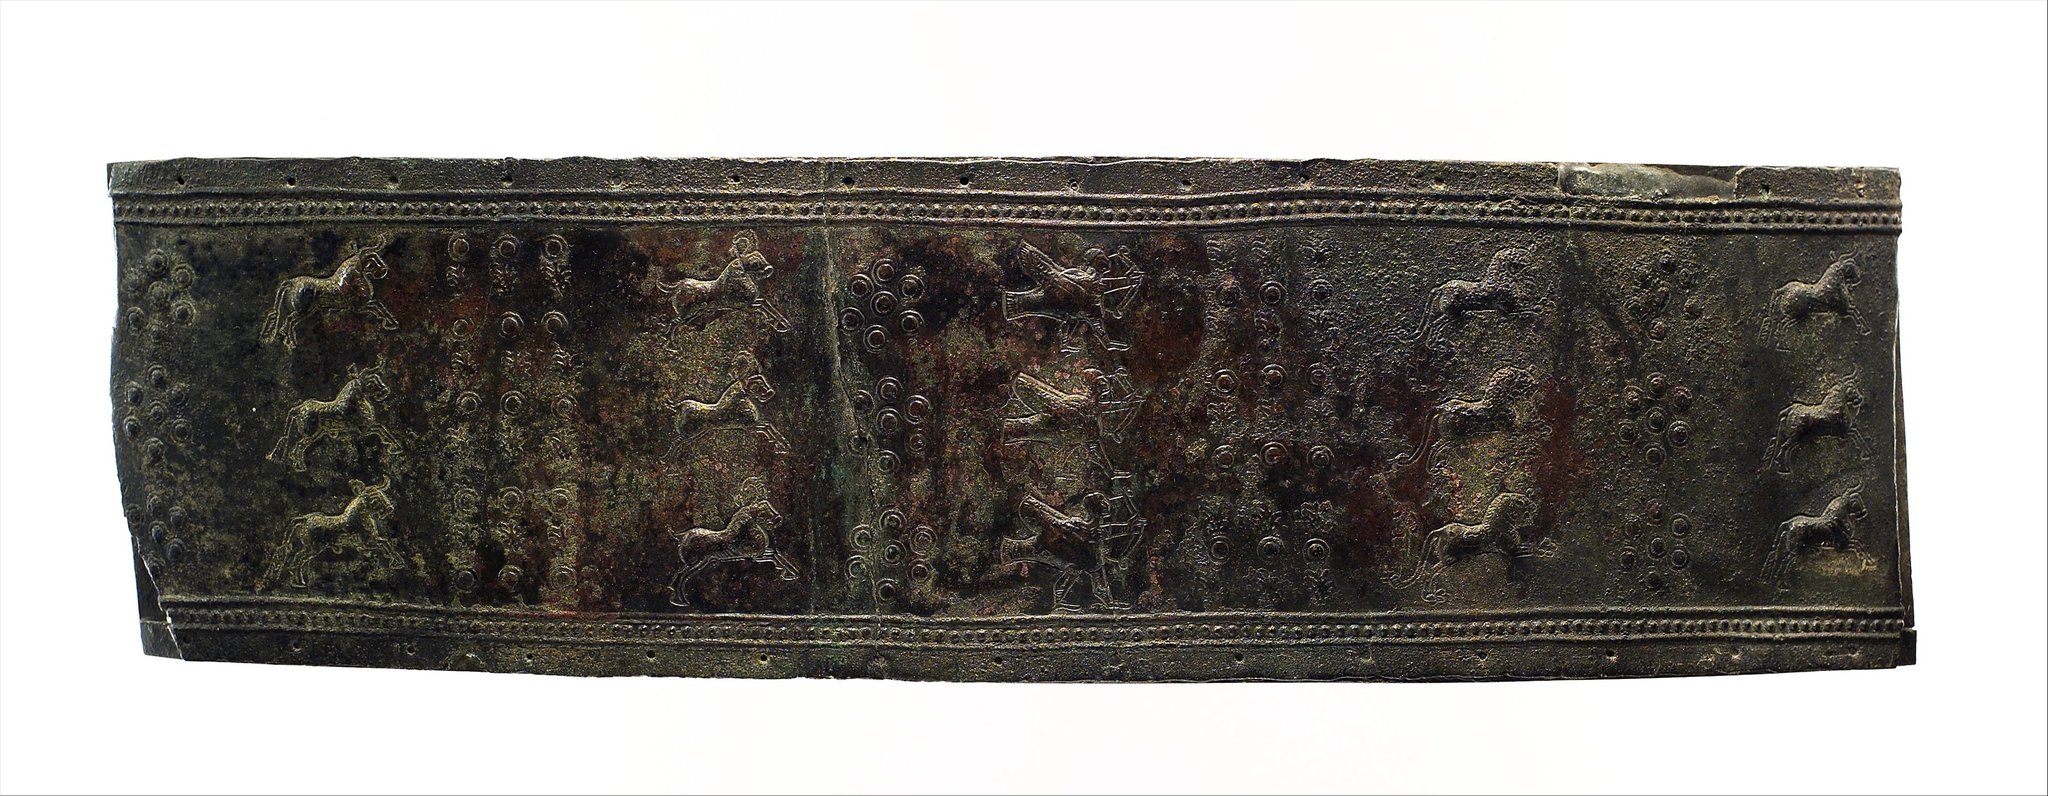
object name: belt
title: Belt fragment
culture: urartian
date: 700-601 BCE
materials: bronze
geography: urartu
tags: hunting,bulls,lions